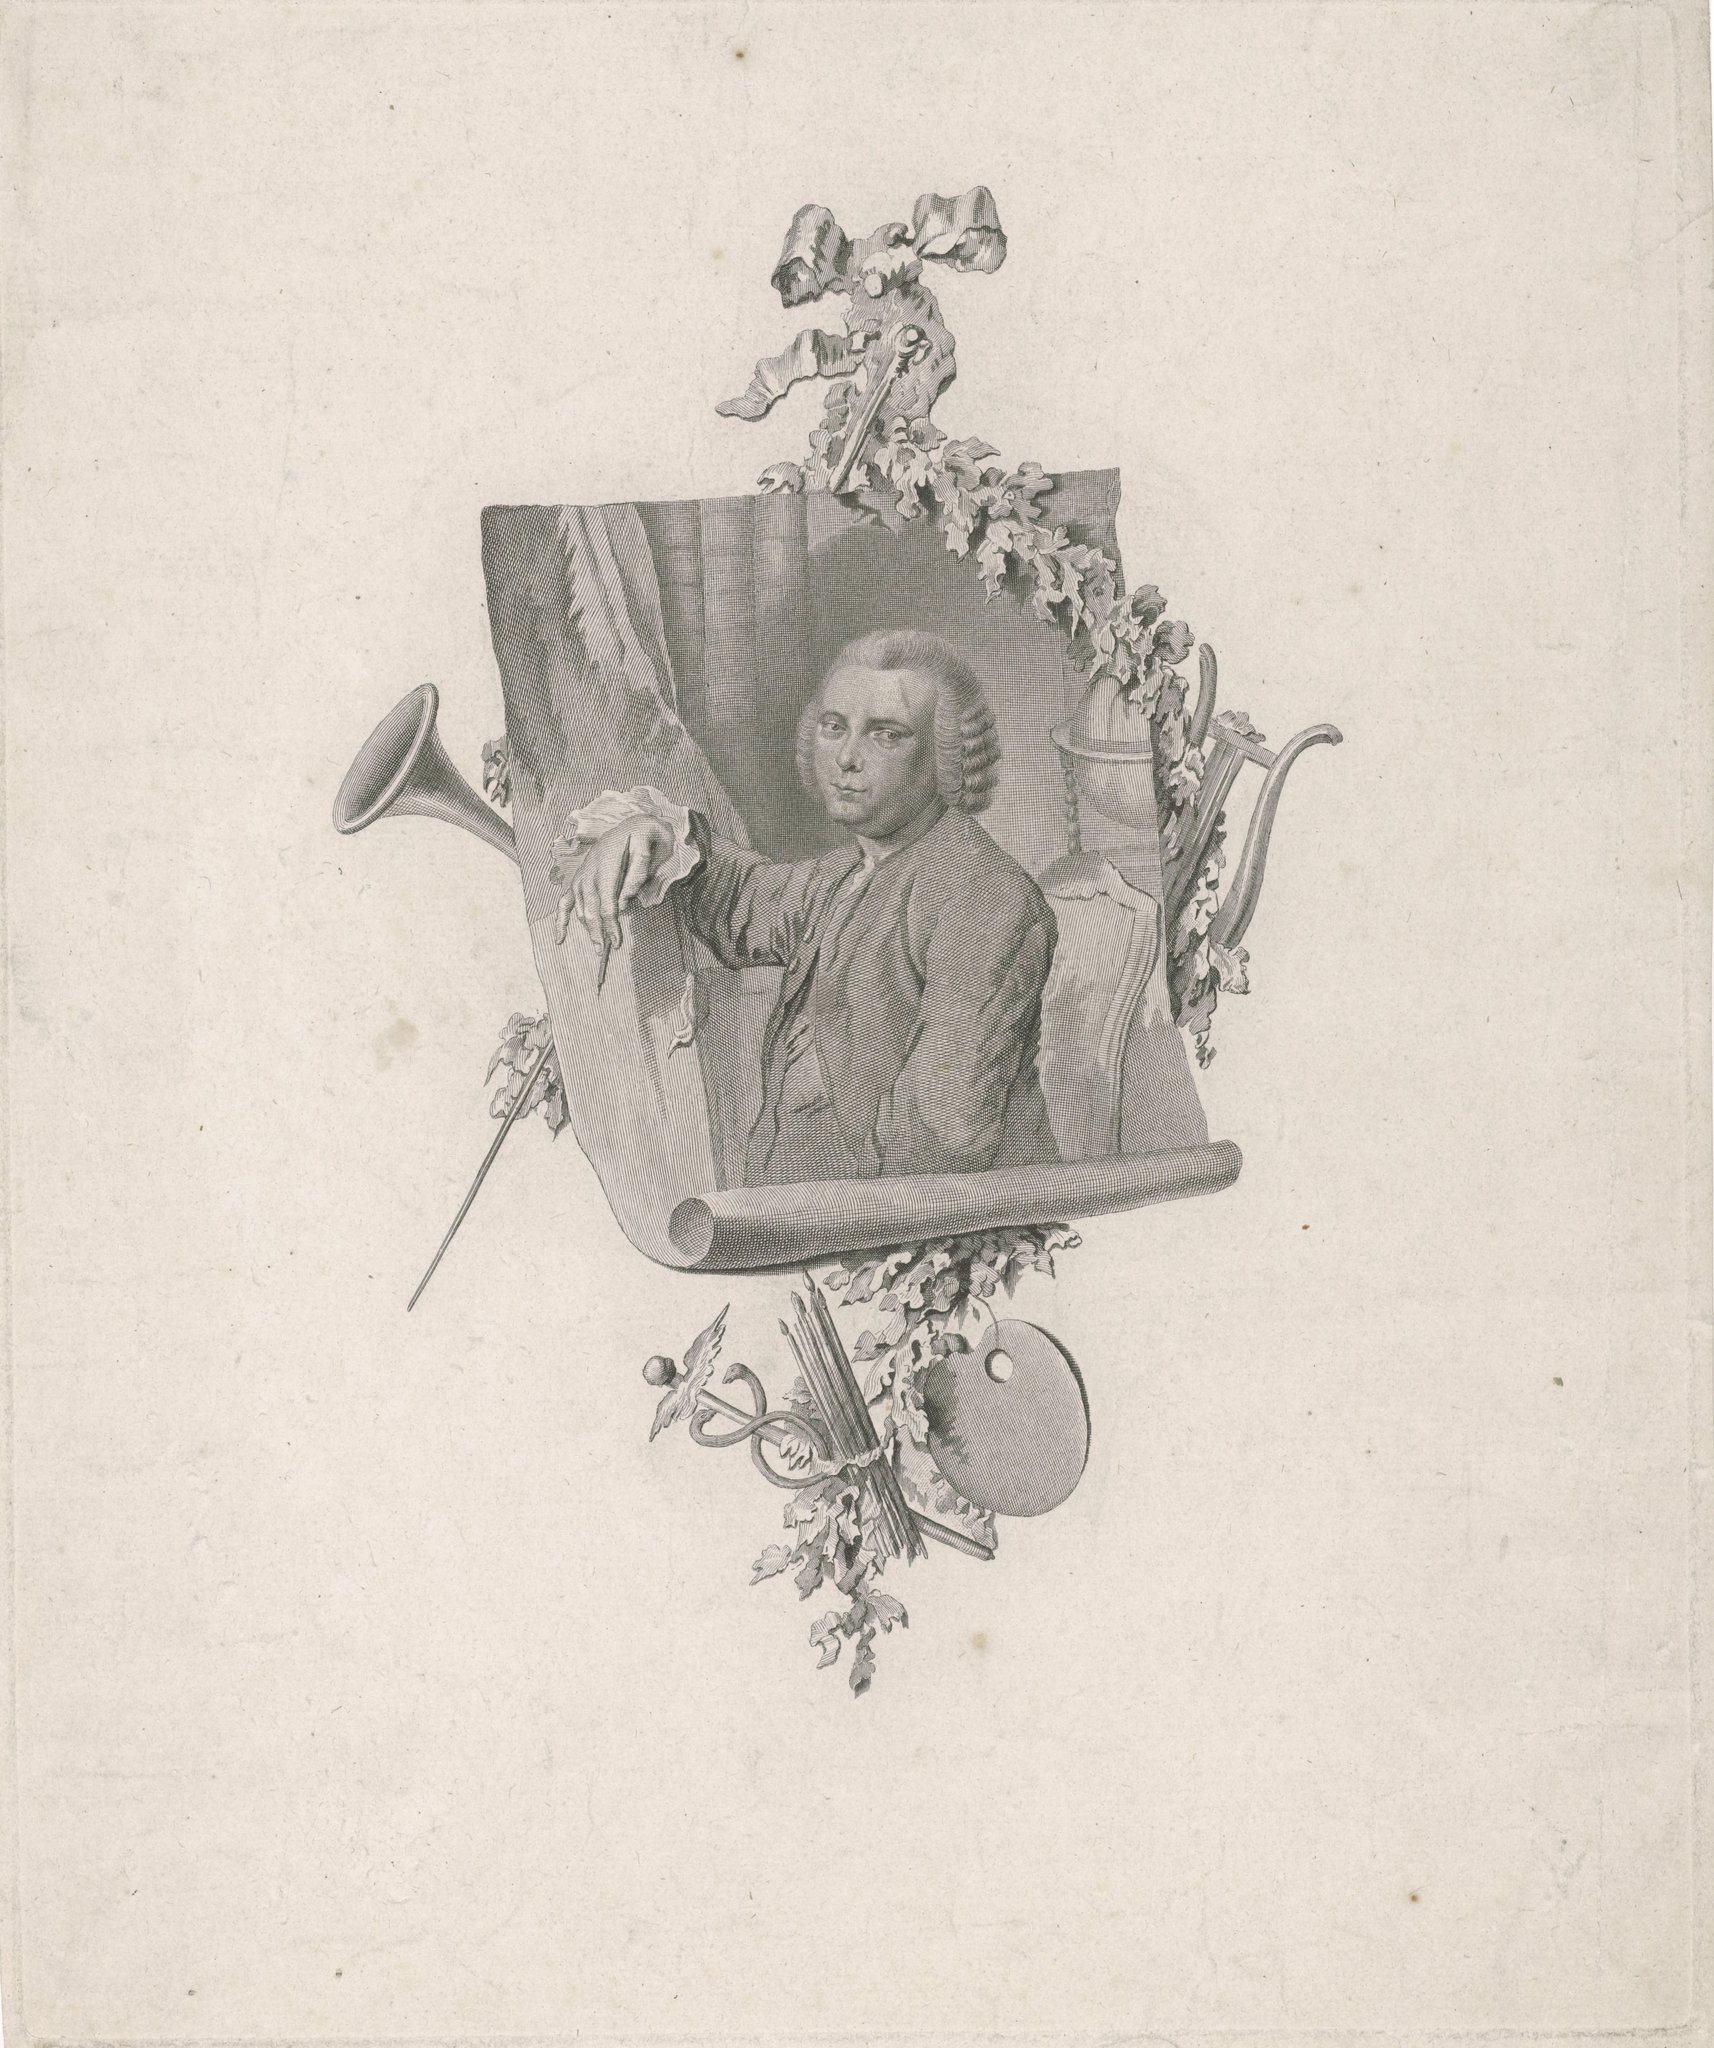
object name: print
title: Portret van Cornelis Ploos van Amstel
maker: noach van der meer (ii)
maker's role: draughtsman, print maker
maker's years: 1741-1822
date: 1751-1798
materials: paper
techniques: etching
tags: amsterdam, print maker, draughtsman, cornelis ploos van amstel, historical persons, portrait, self-portrait of graphic artist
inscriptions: collector's mark: Lugt 2228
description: Portret van graveur en verzamelaar Cornelis Ploos van Amstel. Achter het portret loofwerk met een trompet en een lier. Onderaan een palet, penselen en een caduceus.